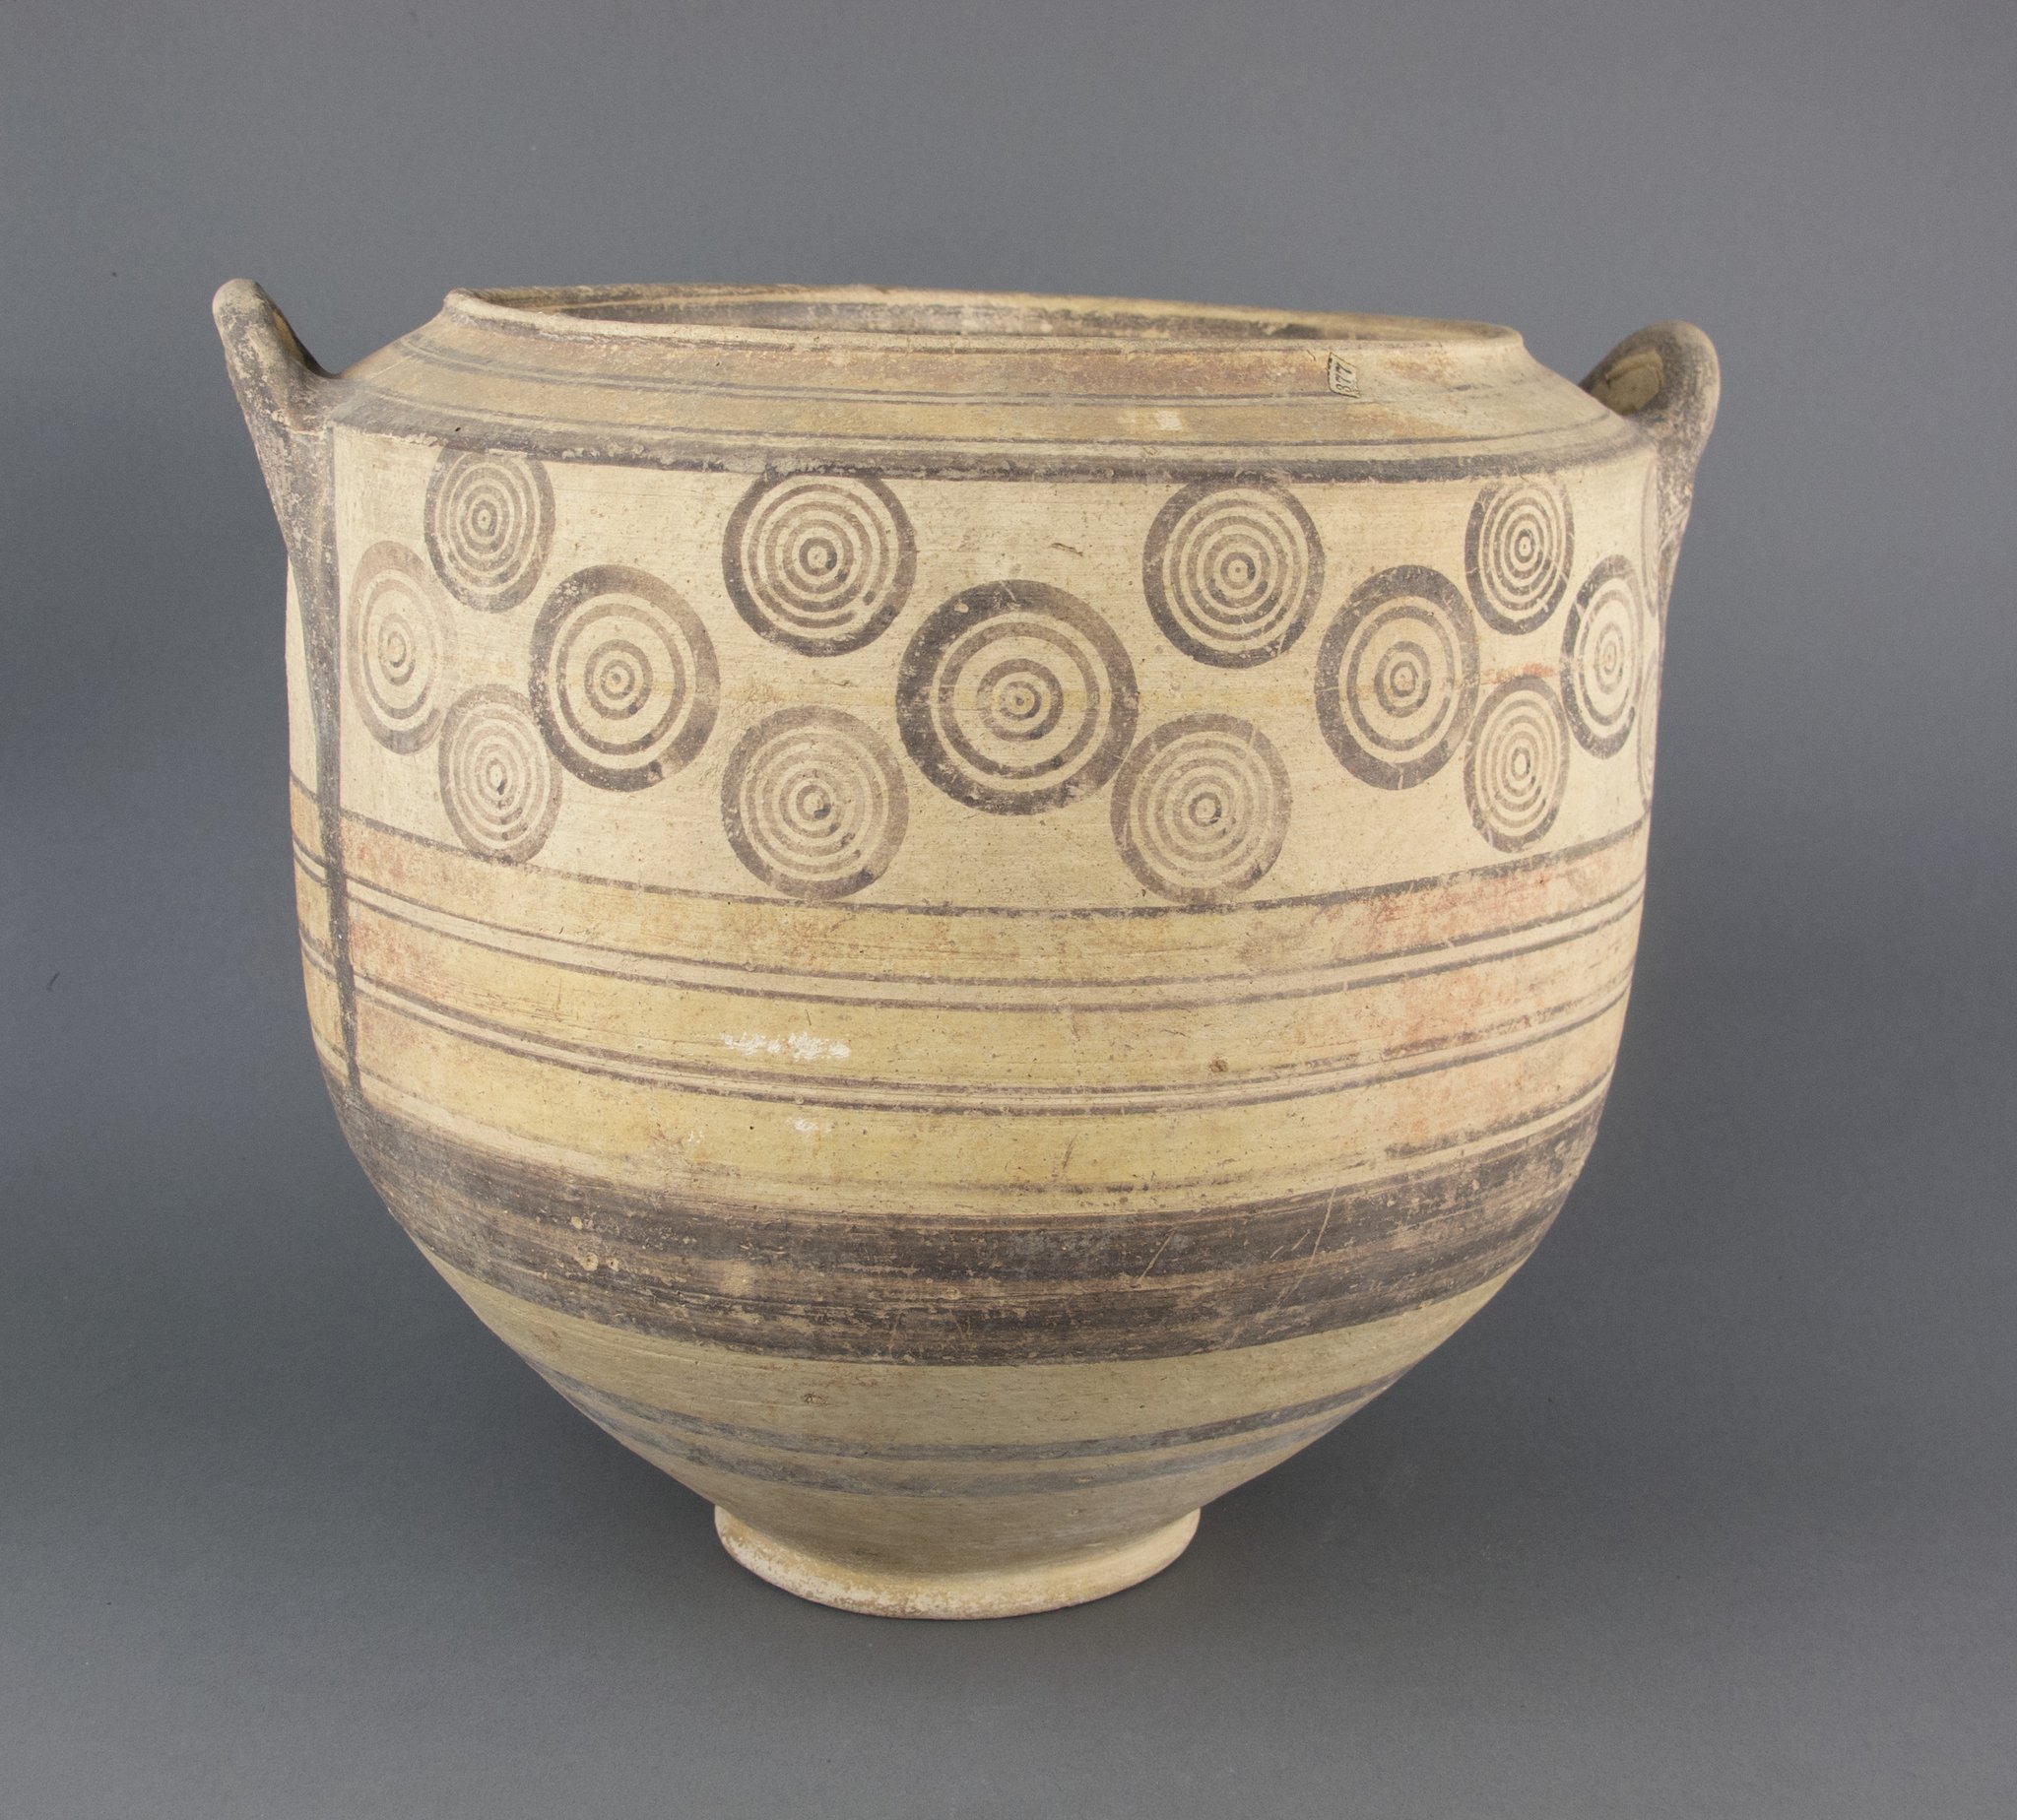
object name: dinos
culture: cypriot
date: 600-480 BCE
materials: terracotta